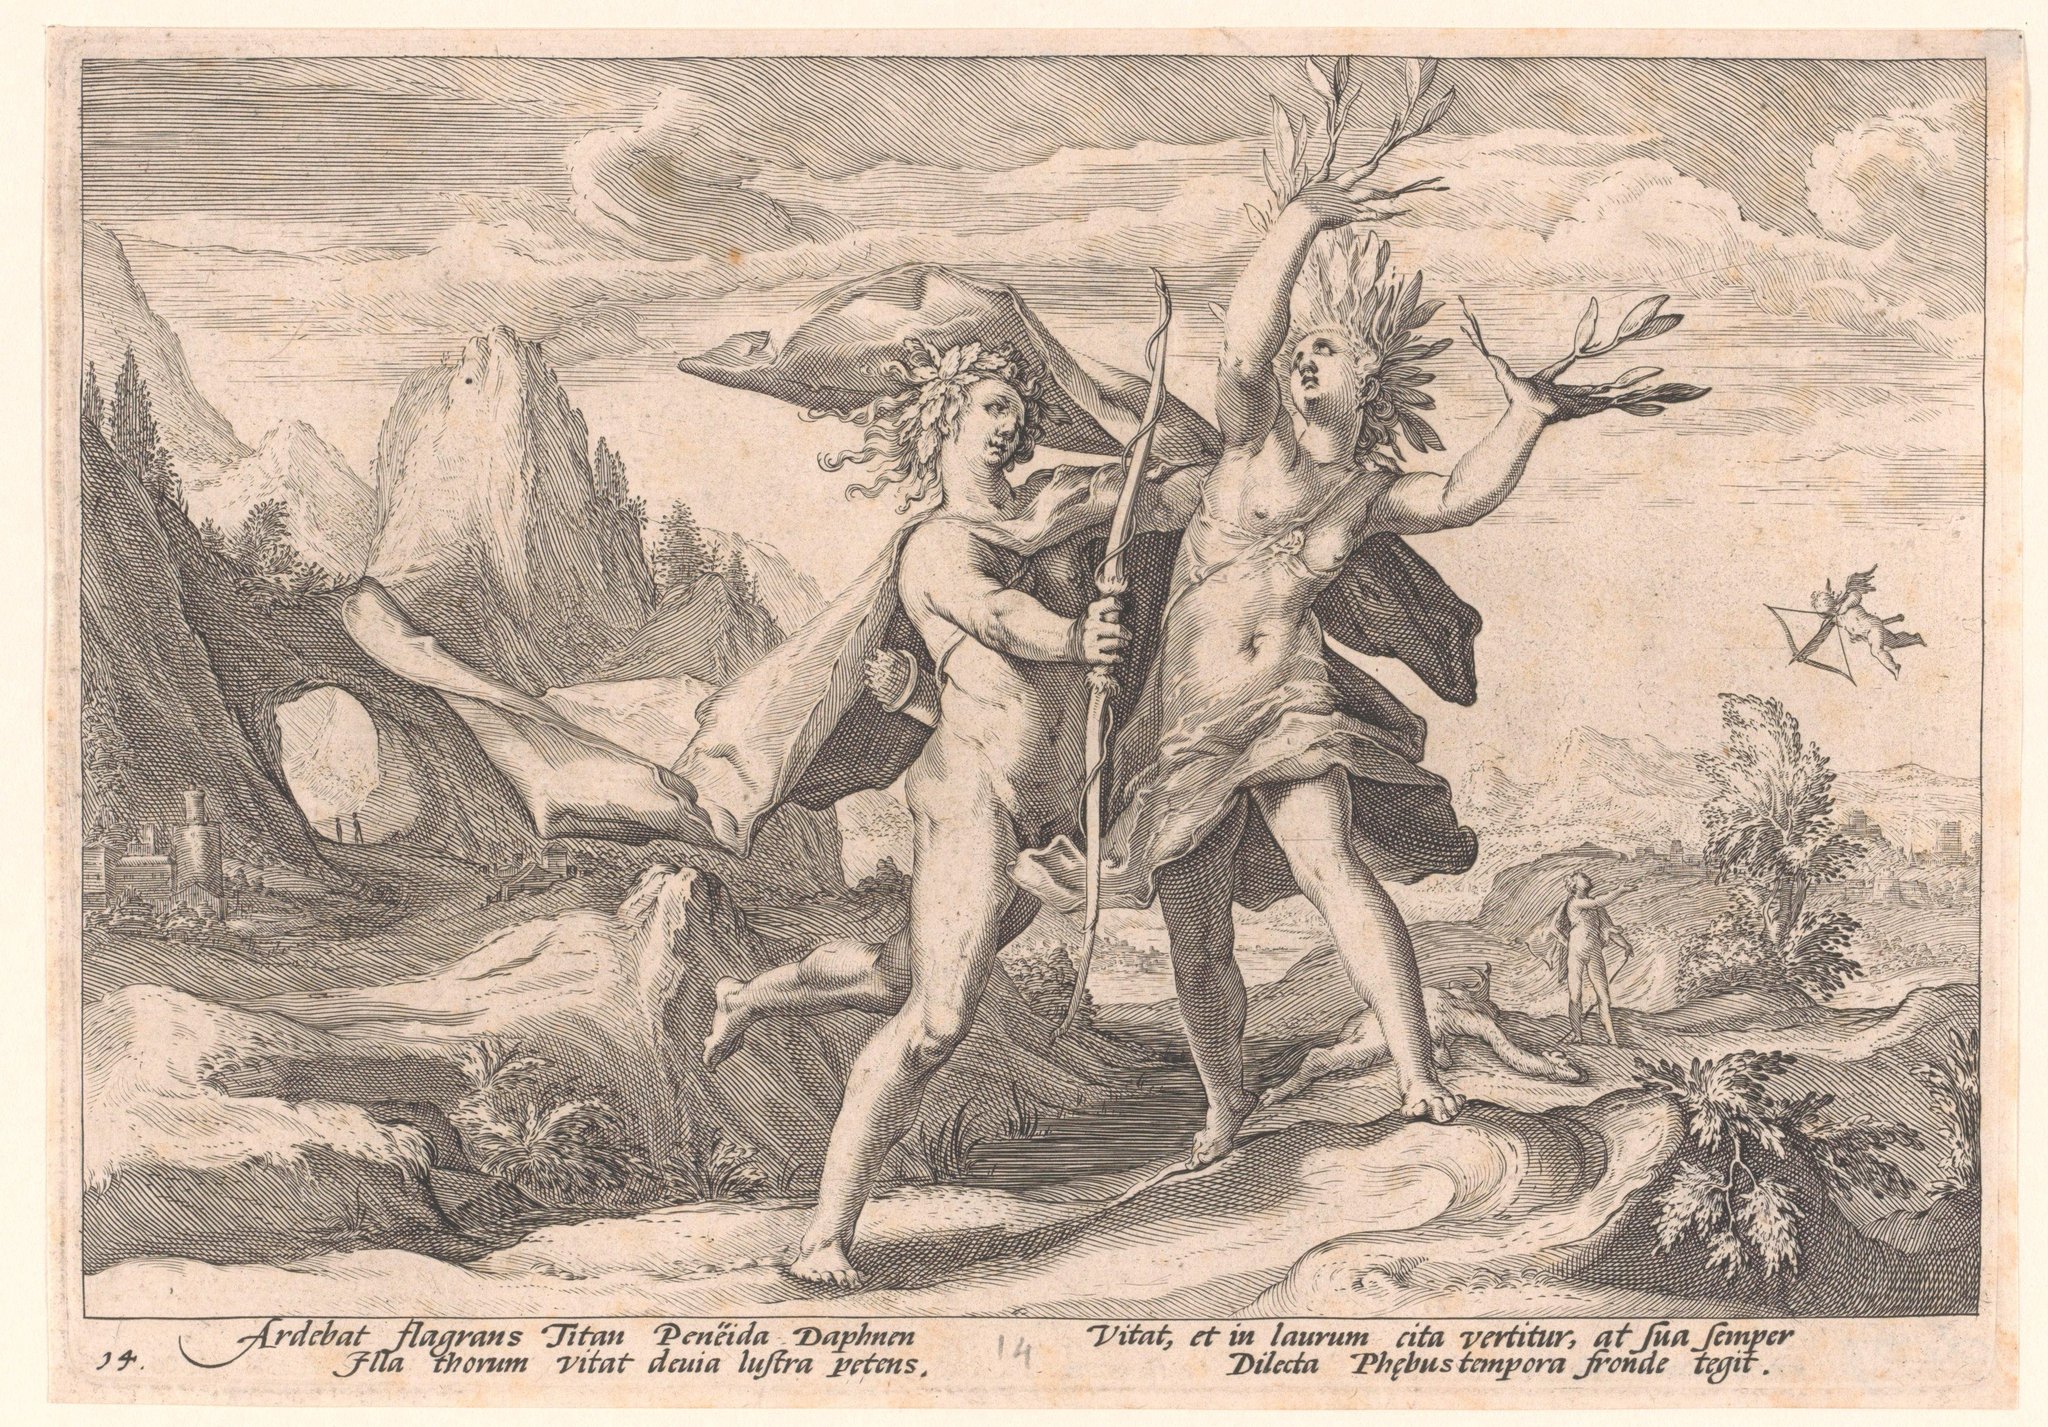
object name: print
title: Metamorfosen van Ovidius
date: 1589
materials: paper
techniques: engraving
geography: haarlem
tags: daphne changed into a laurel-tree: while fleeing from apollo, daphne is changed into a laurel-tree by her father peneus (ovid, metamorphoses i 548)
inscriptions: collector's mark: Lugt 11, collector's mark: ‘Hinloopen’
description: Toen de nimf Daphne achtervolgd werd door Apollo, die verliefd op haar was geworden, smeekte zij haar vader Peneus om hulp. Deze zorgde ervoor dat zijn dochter ontkwam aan haar belager door haar te veranderen in een laurierboom. Te zien is het moment waarop Daphnes armen veranderen in bebladerde takken, terwijl Apollo haar juist vast wil grijpen. Op de achtergrond Amor die Apollo, bij het dode lijf van Python, met een van zijn pijlen treft. In de ondermarge een vierregelige toelichting, in twee kolommen, in het Latijn.